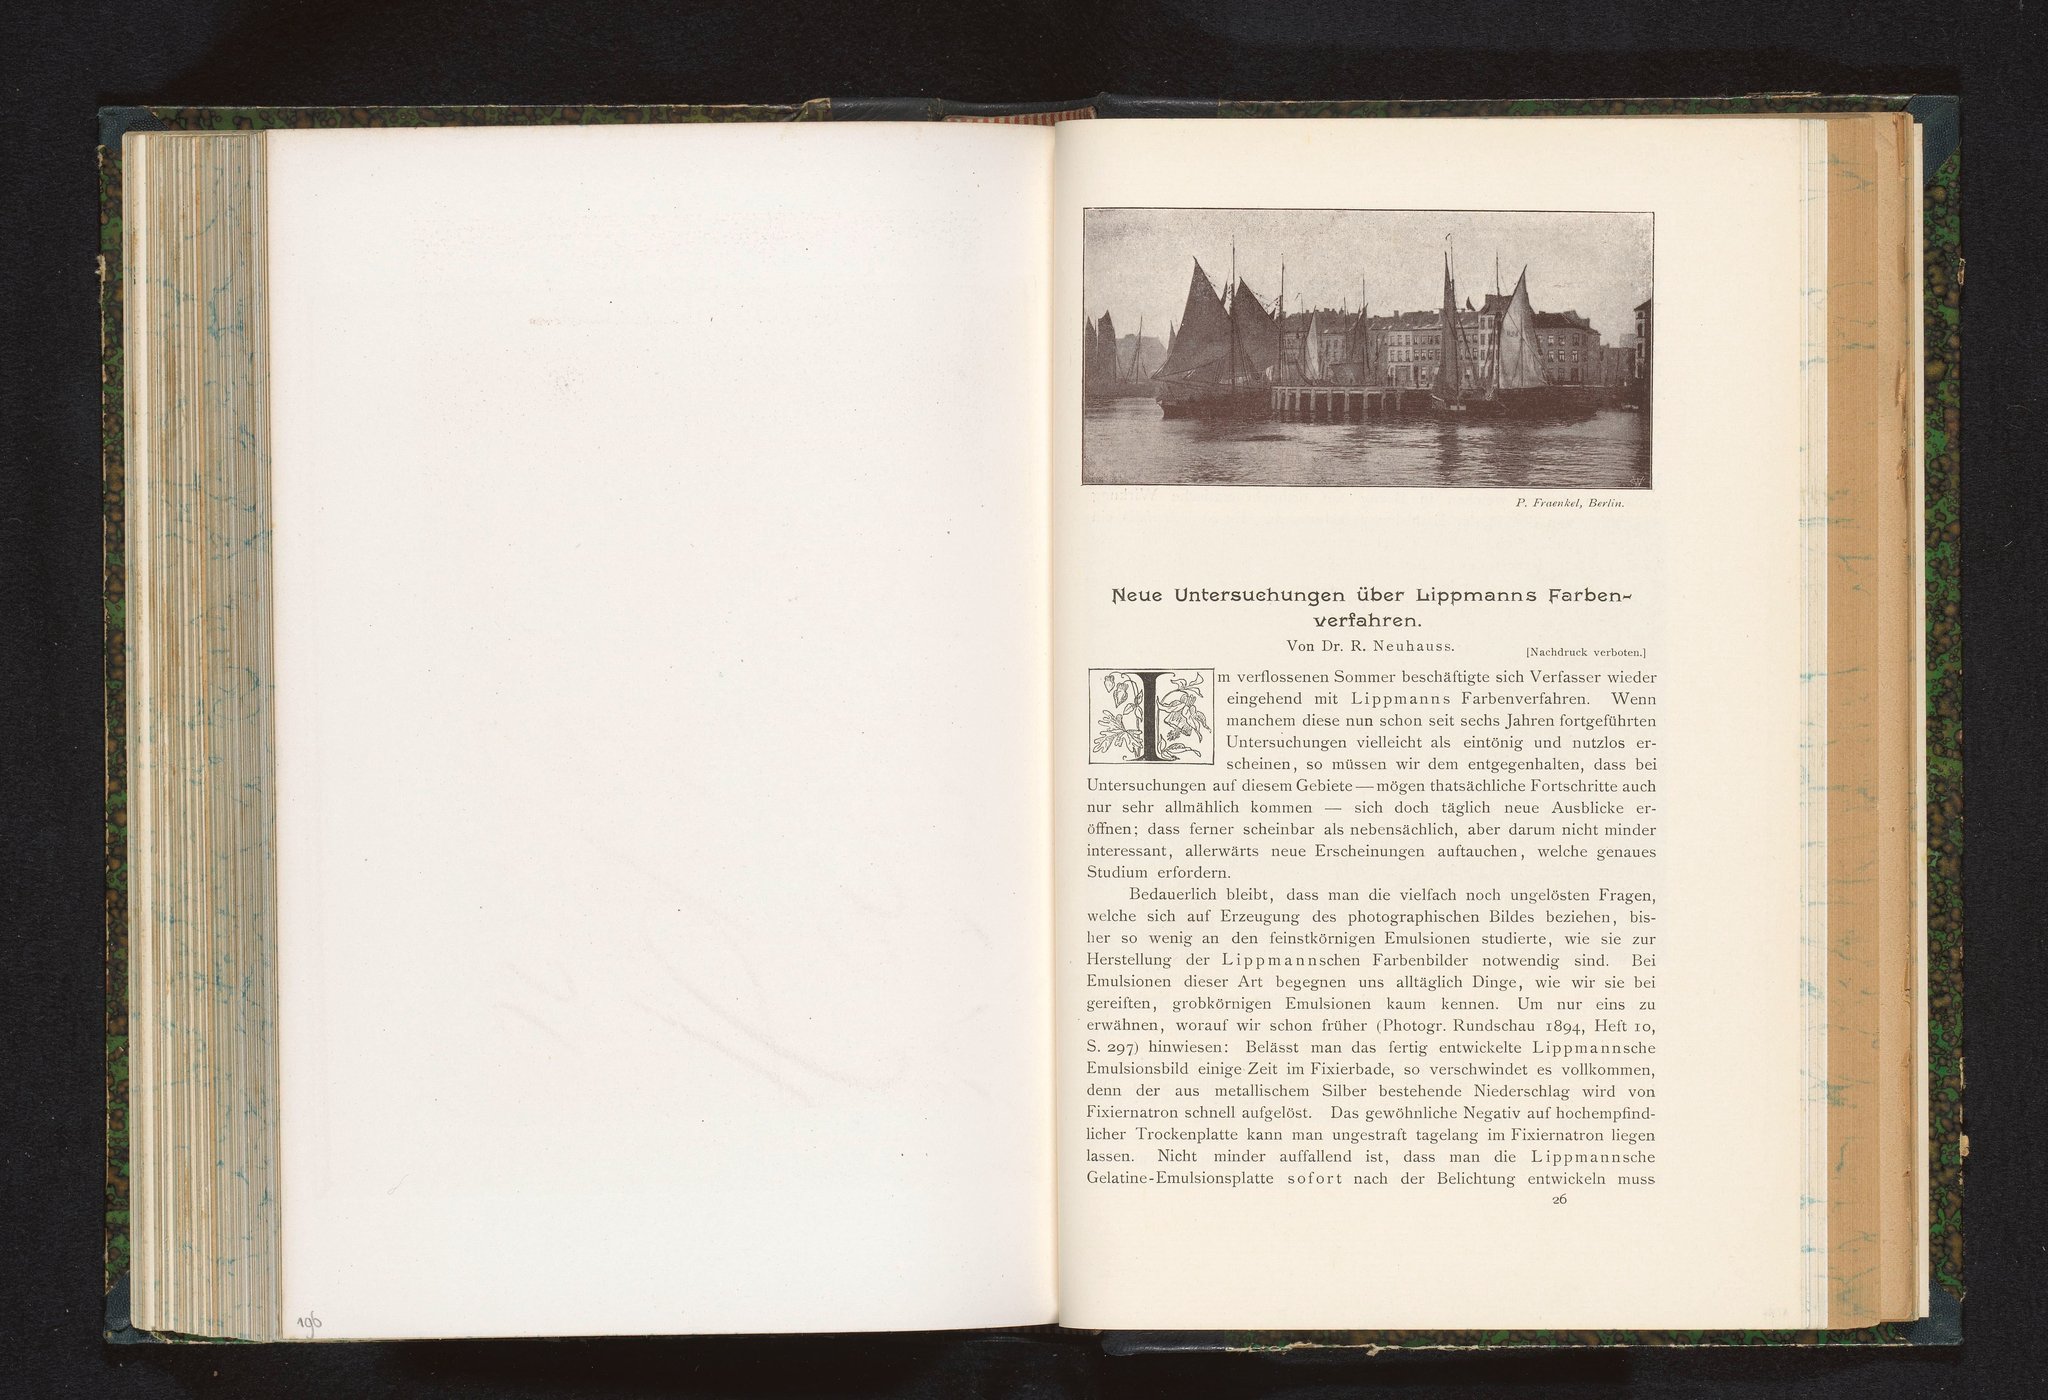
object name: photomechanical print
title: Haven met aangemeerde zeilboten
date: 1894-1899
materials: paper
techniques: autotype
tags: harbour, sailing-ship, sailing-boat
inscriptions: monogram: ‘CW’